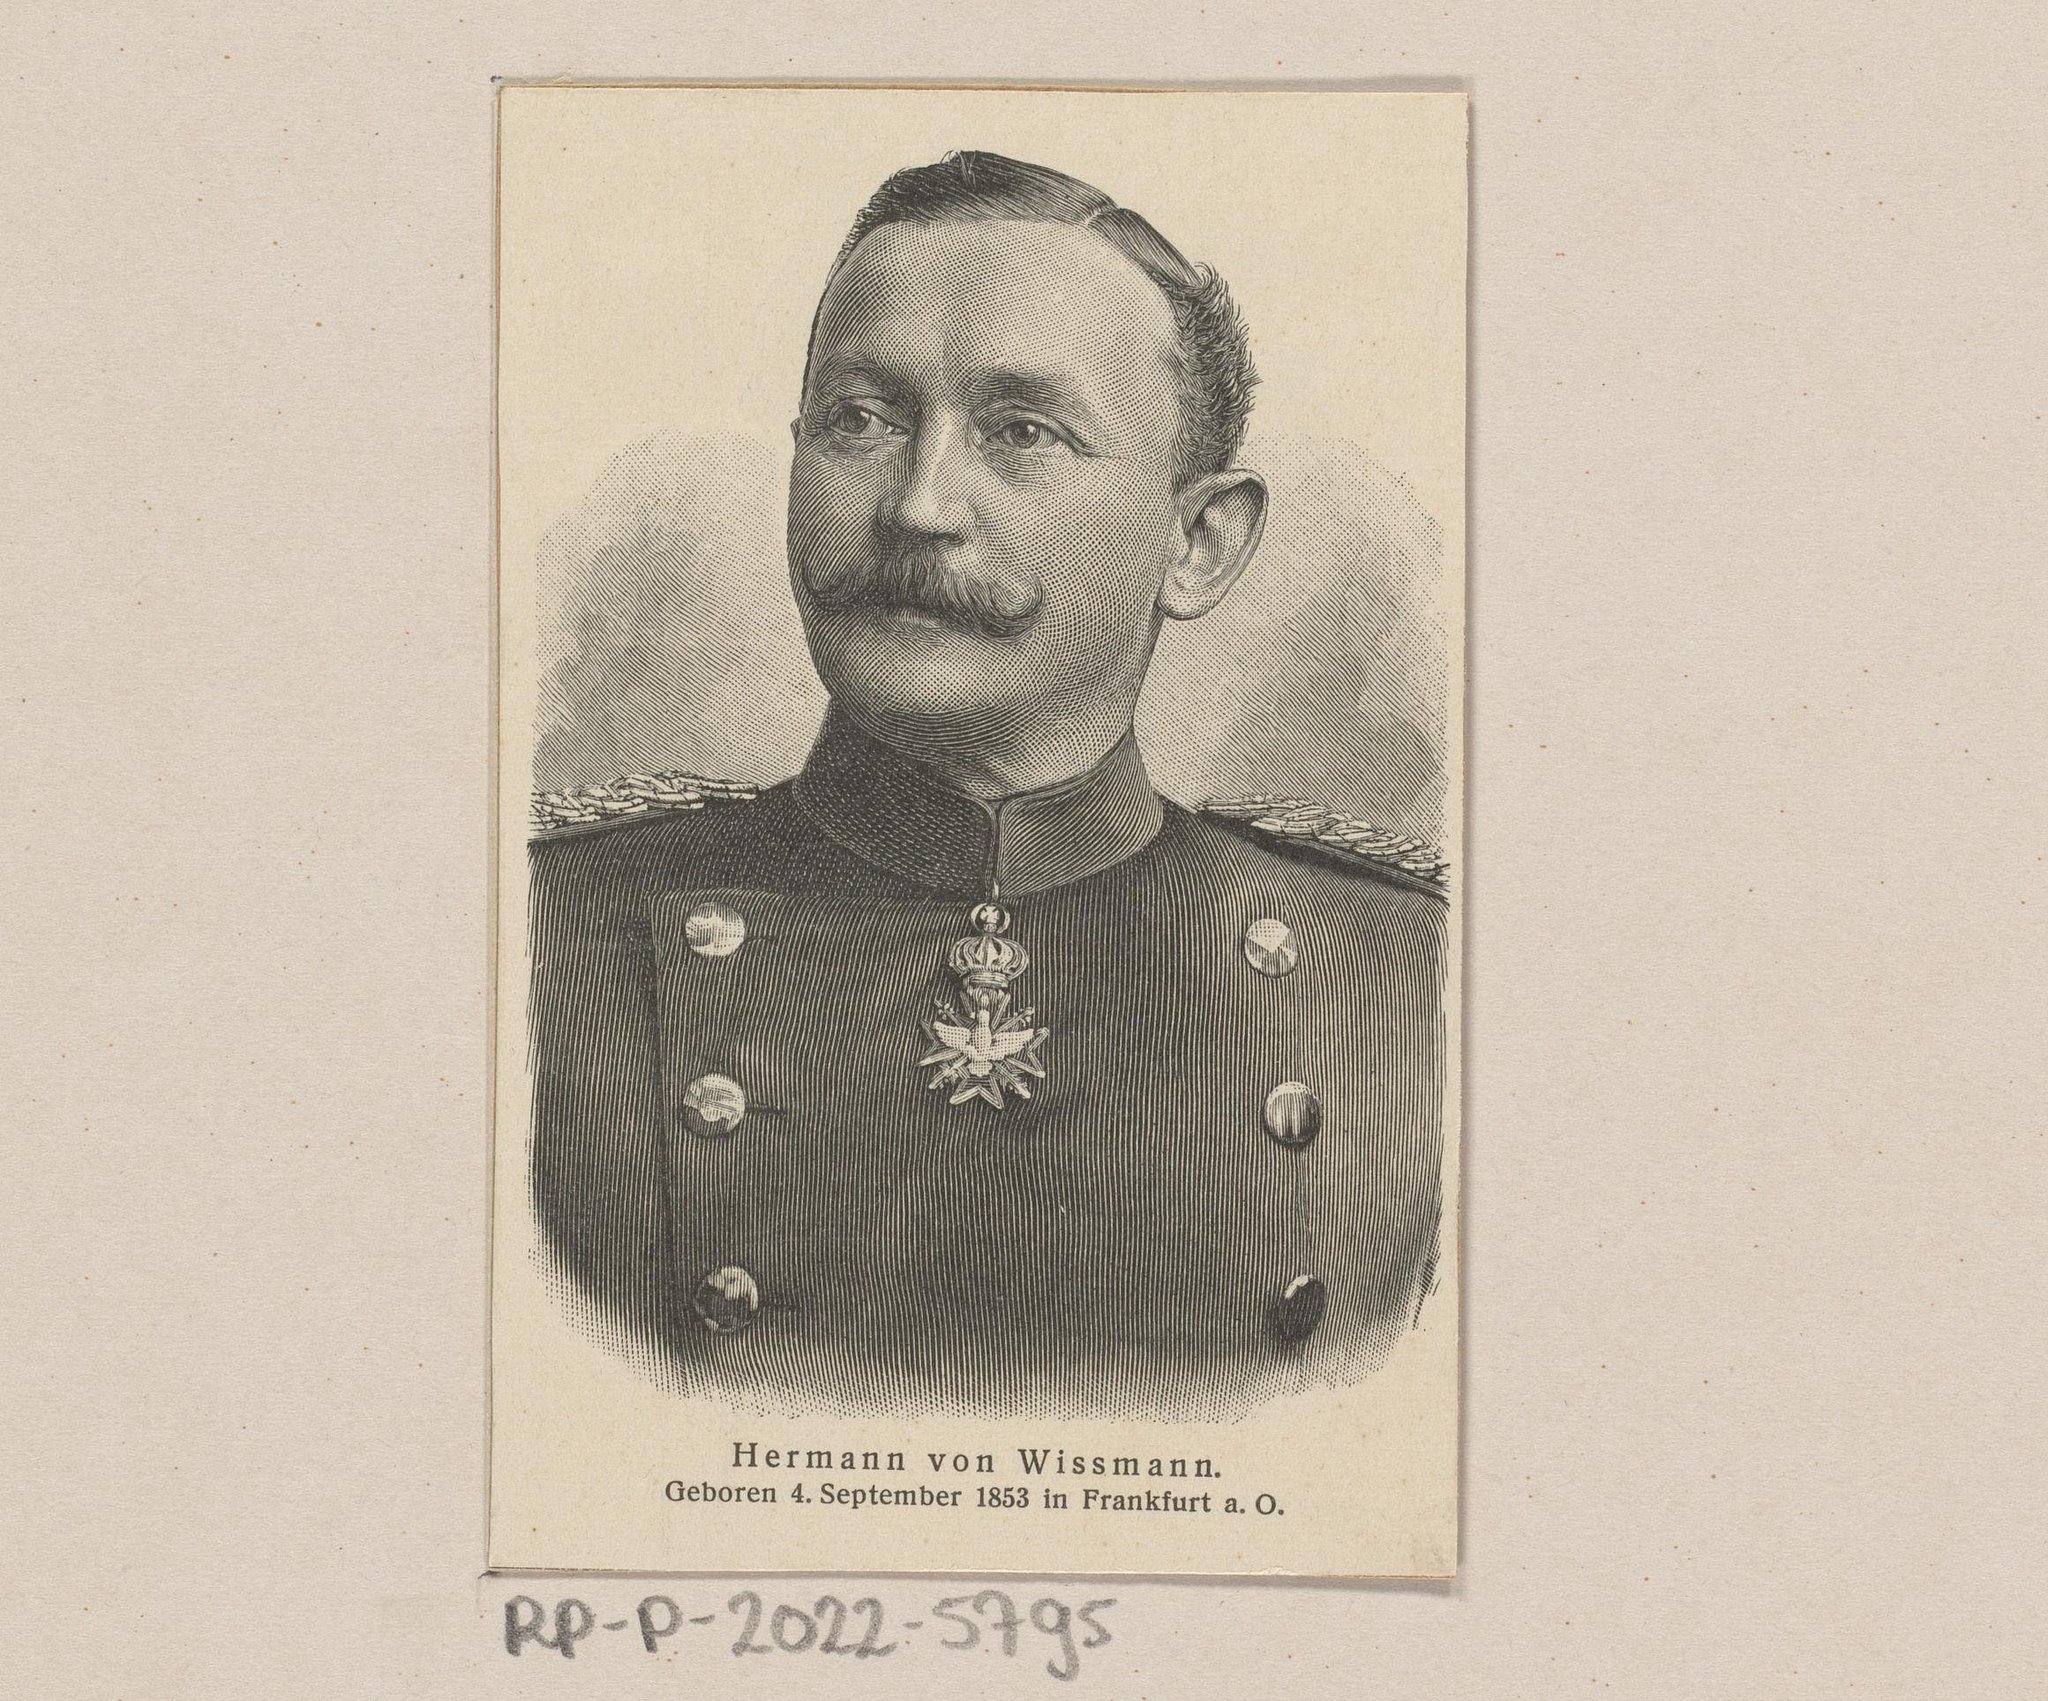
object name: print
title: Portret van Hermann von Wissmann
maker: Anonymous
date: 1883-1905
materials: paper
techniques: engraving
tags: historical persons, explorer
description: Met eenregelig onderschrift in het Nederlands.